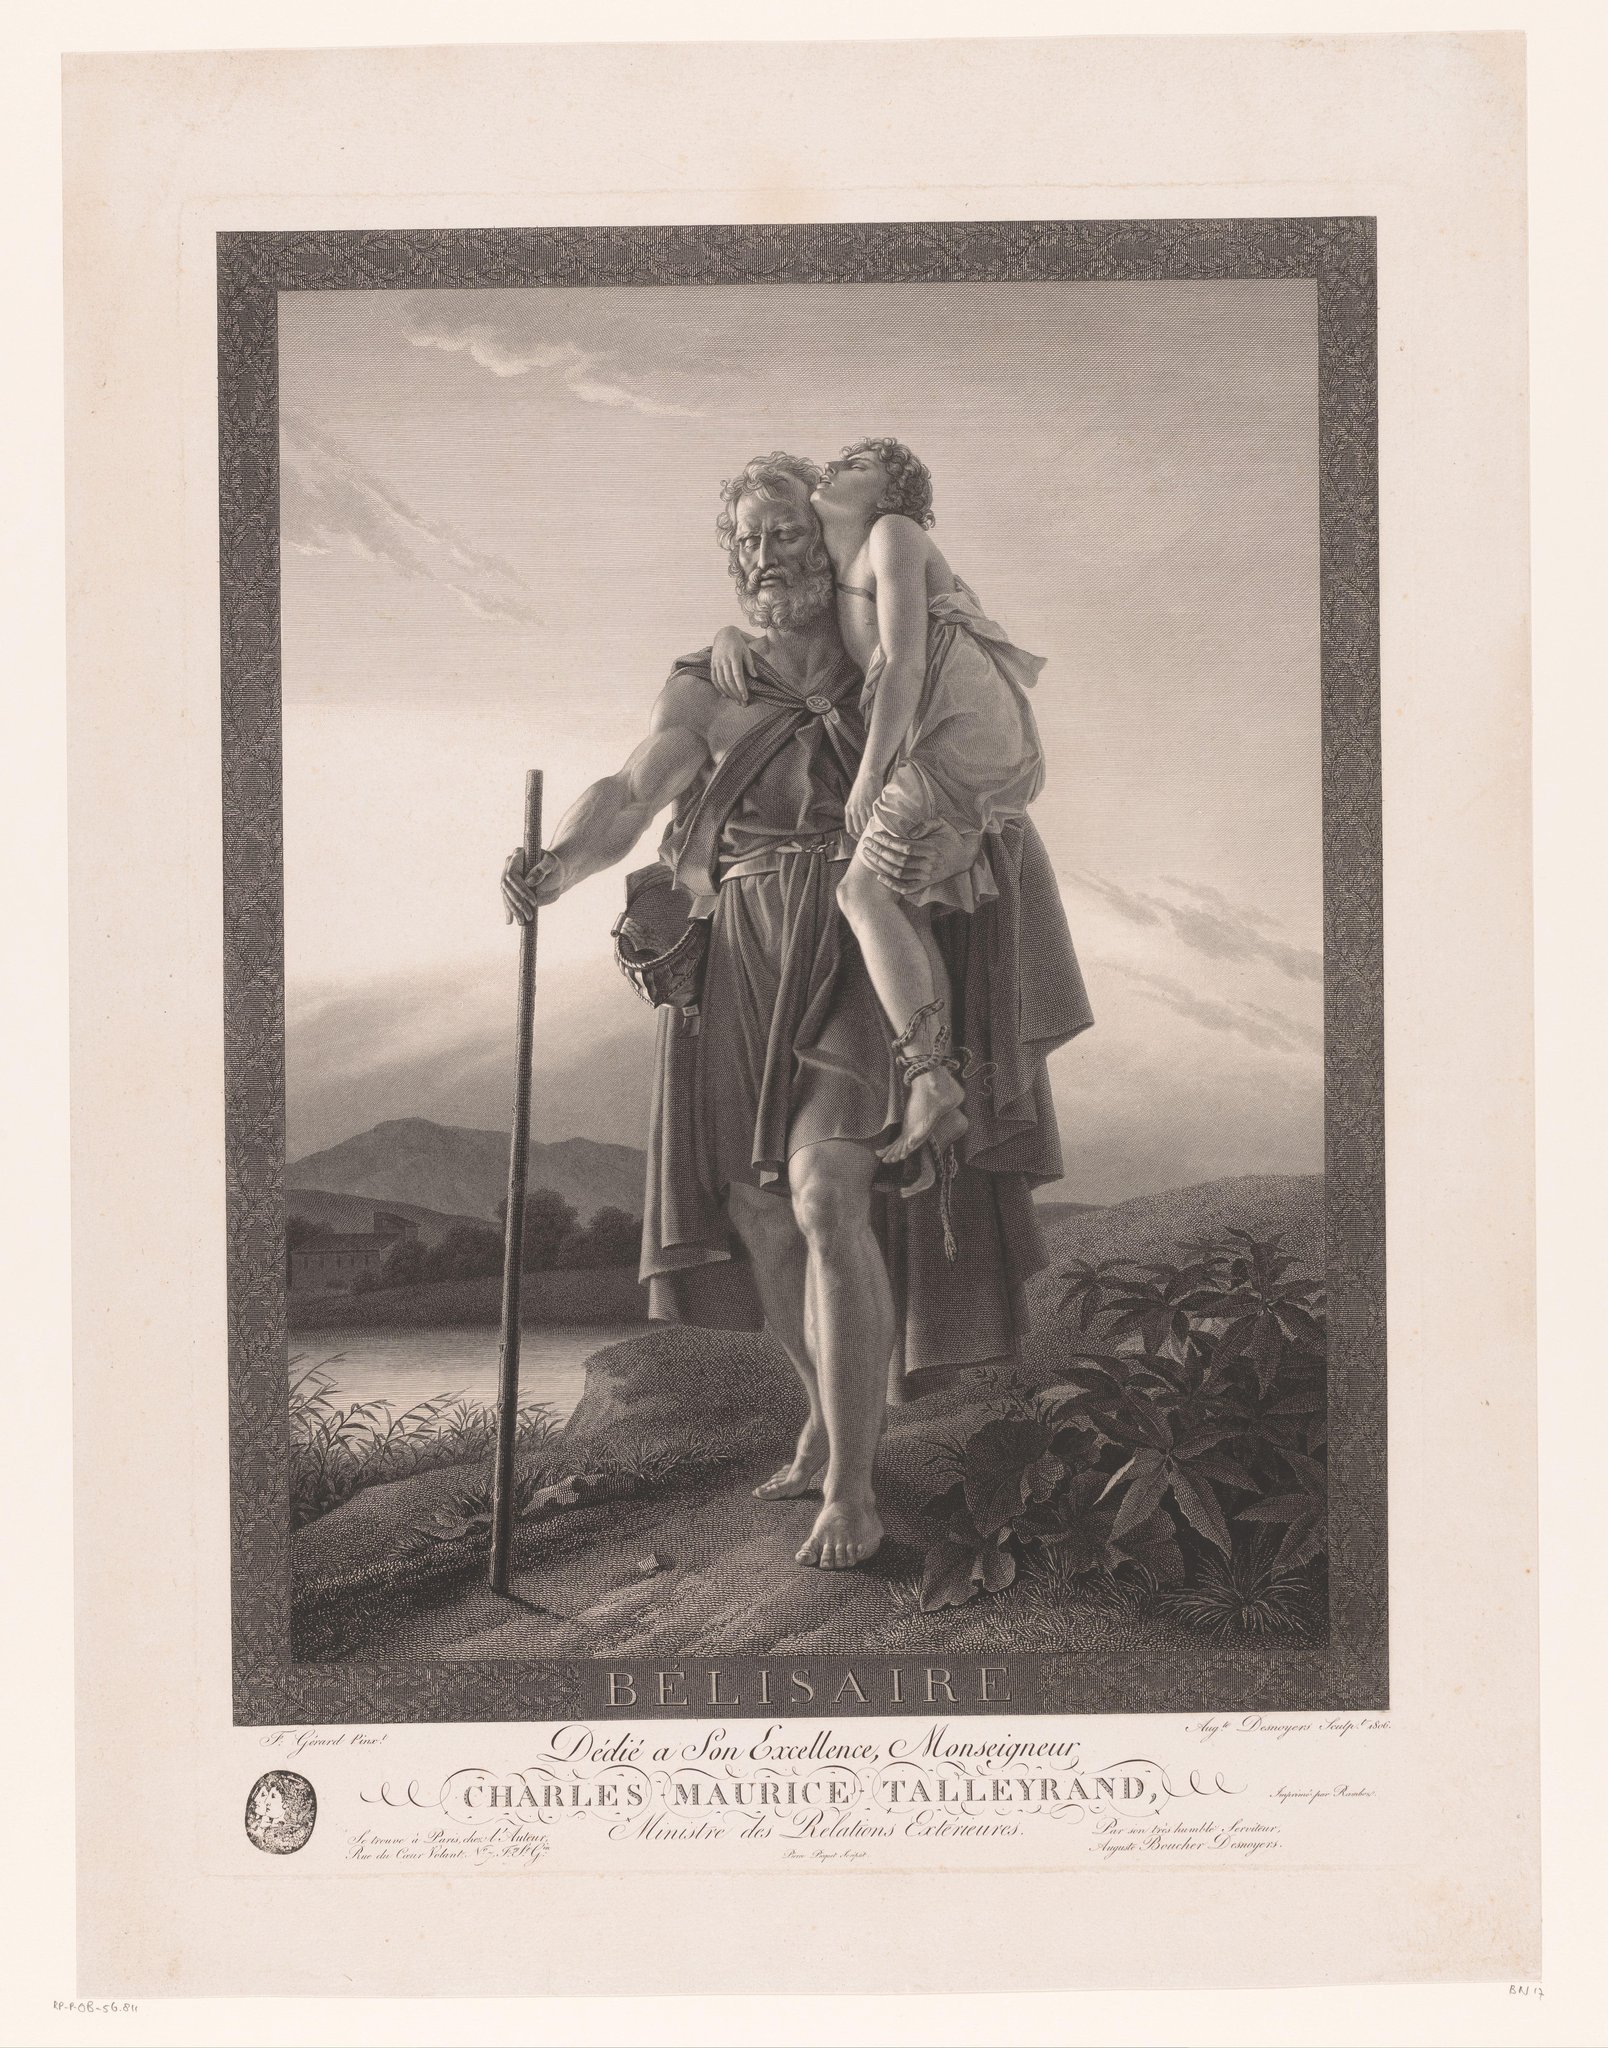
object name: print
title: Belisarius en de jongen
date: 1806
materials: paper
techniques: engraving, etching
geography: france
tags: belisarius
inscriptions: stamp: Lugt 2789, collector's mark: Lugt 2228, collector's mark: Lugt 2760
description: De blinde Belisarius loopt door een landschap. Hij draagt een jongen die door een slang is gebeten.